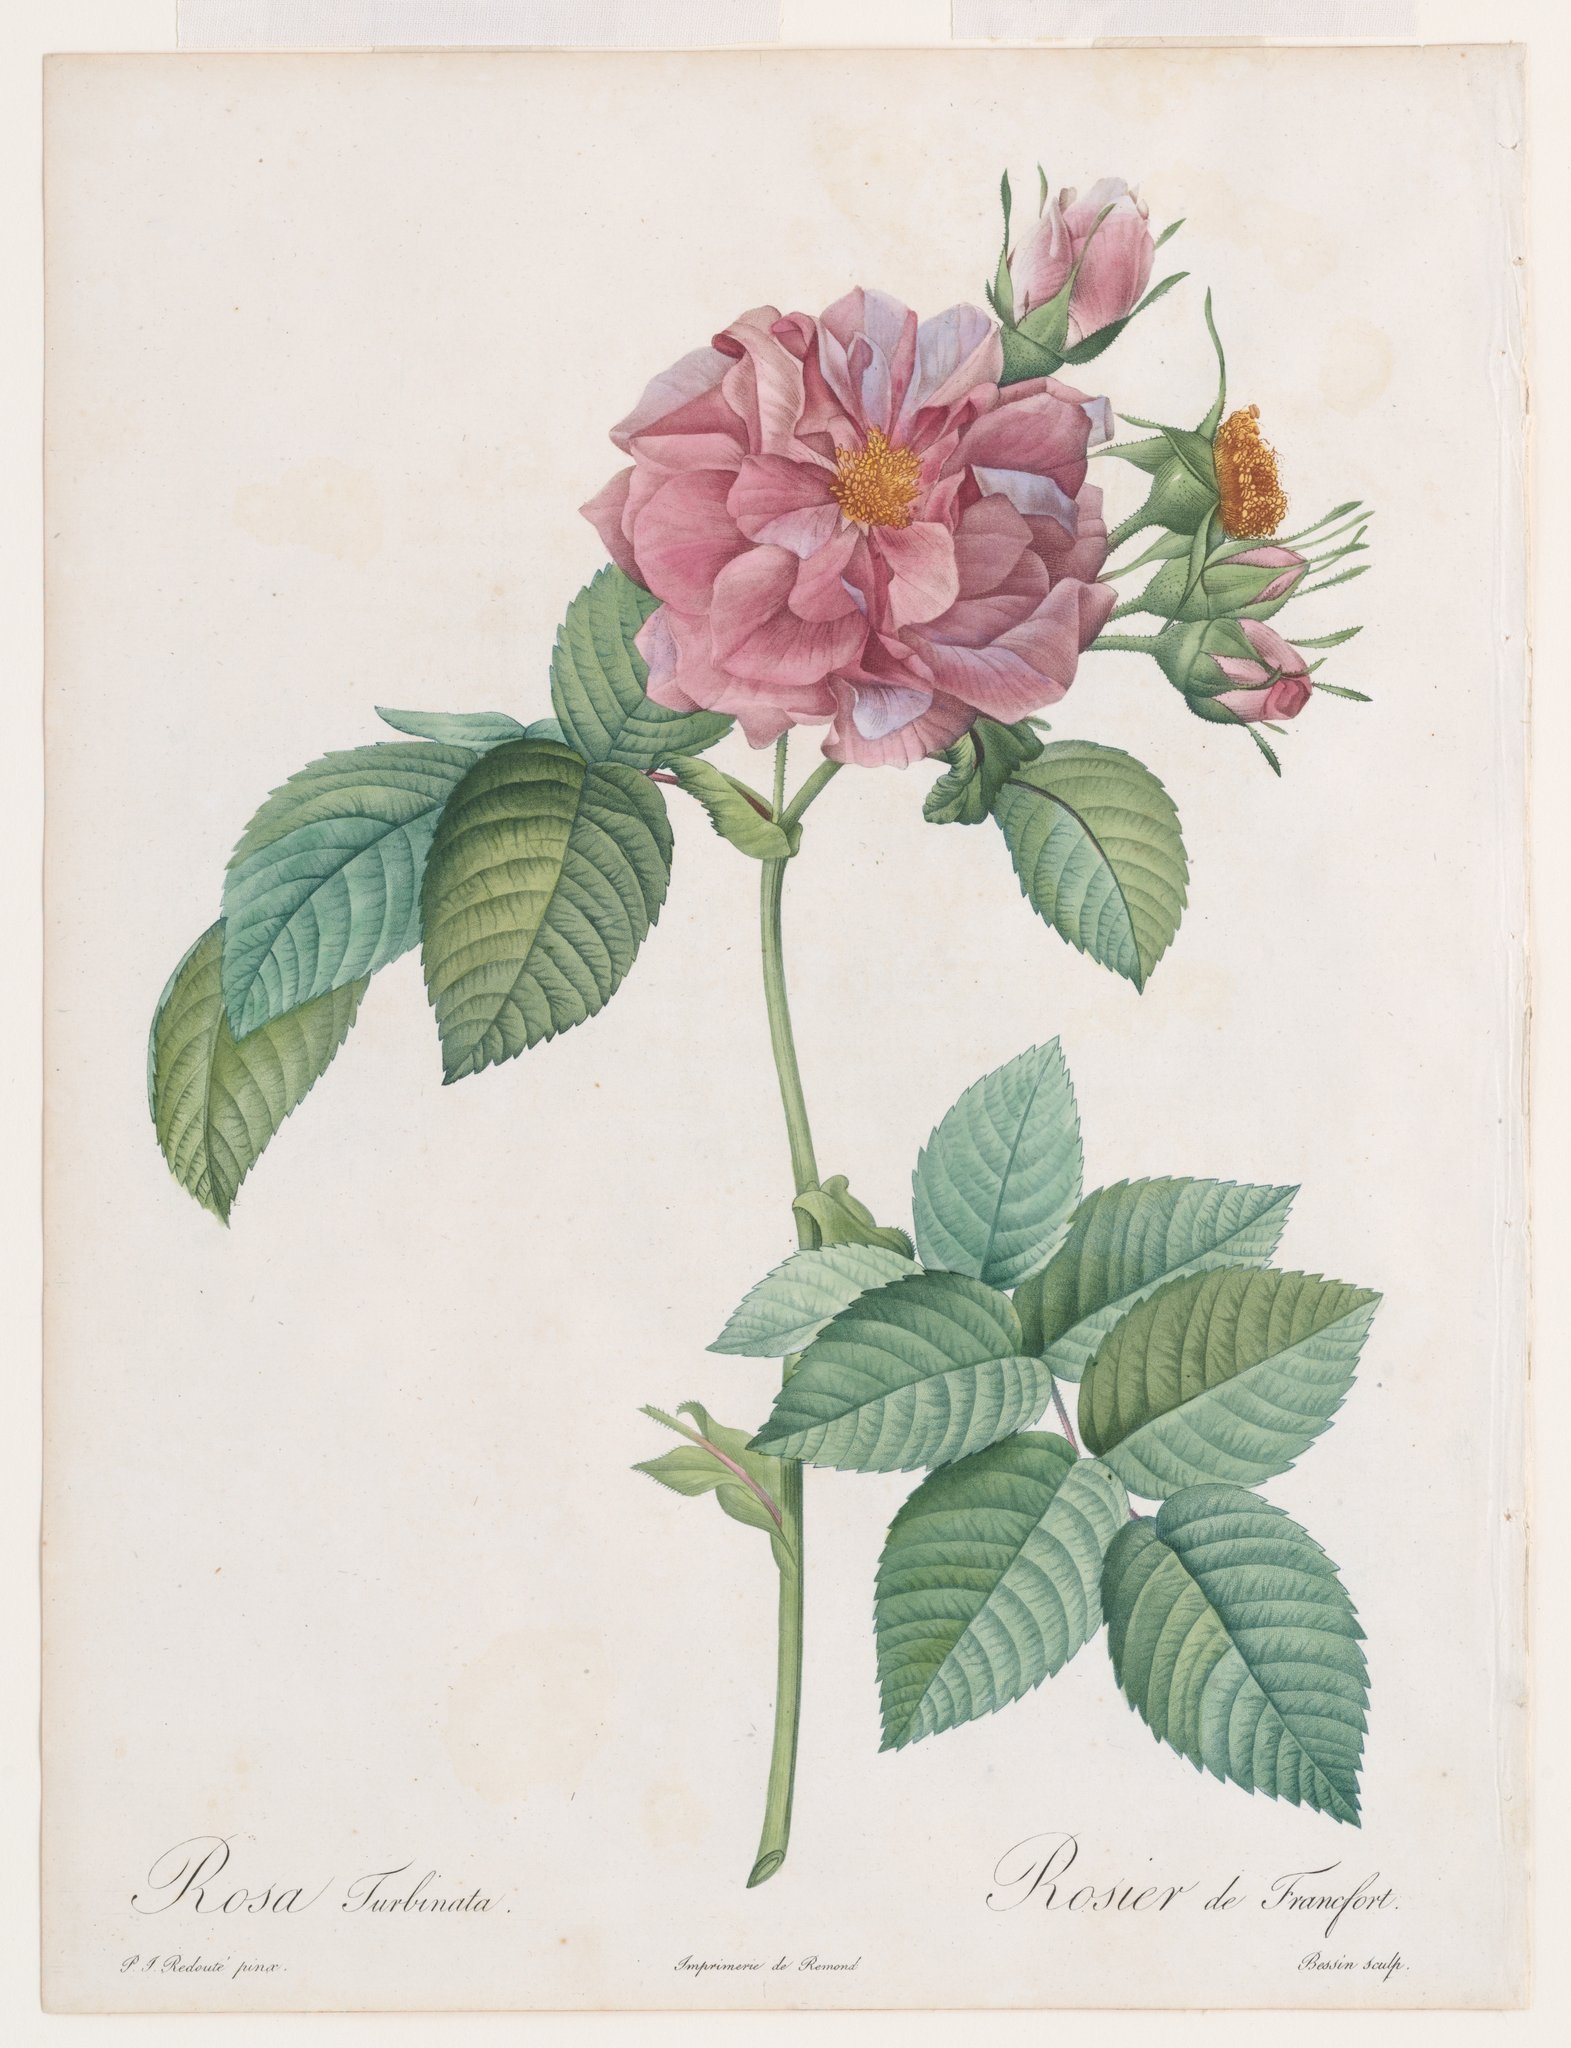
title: ‘Empress Josephine’ or Frankfort Rose (Rosa turbinata), from Claude-Antoine Thory, Les Roses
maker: pierre joseph redouté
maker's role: artist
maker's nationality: french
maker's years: 1759-1840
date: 1817-1824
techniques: engraving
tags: roses